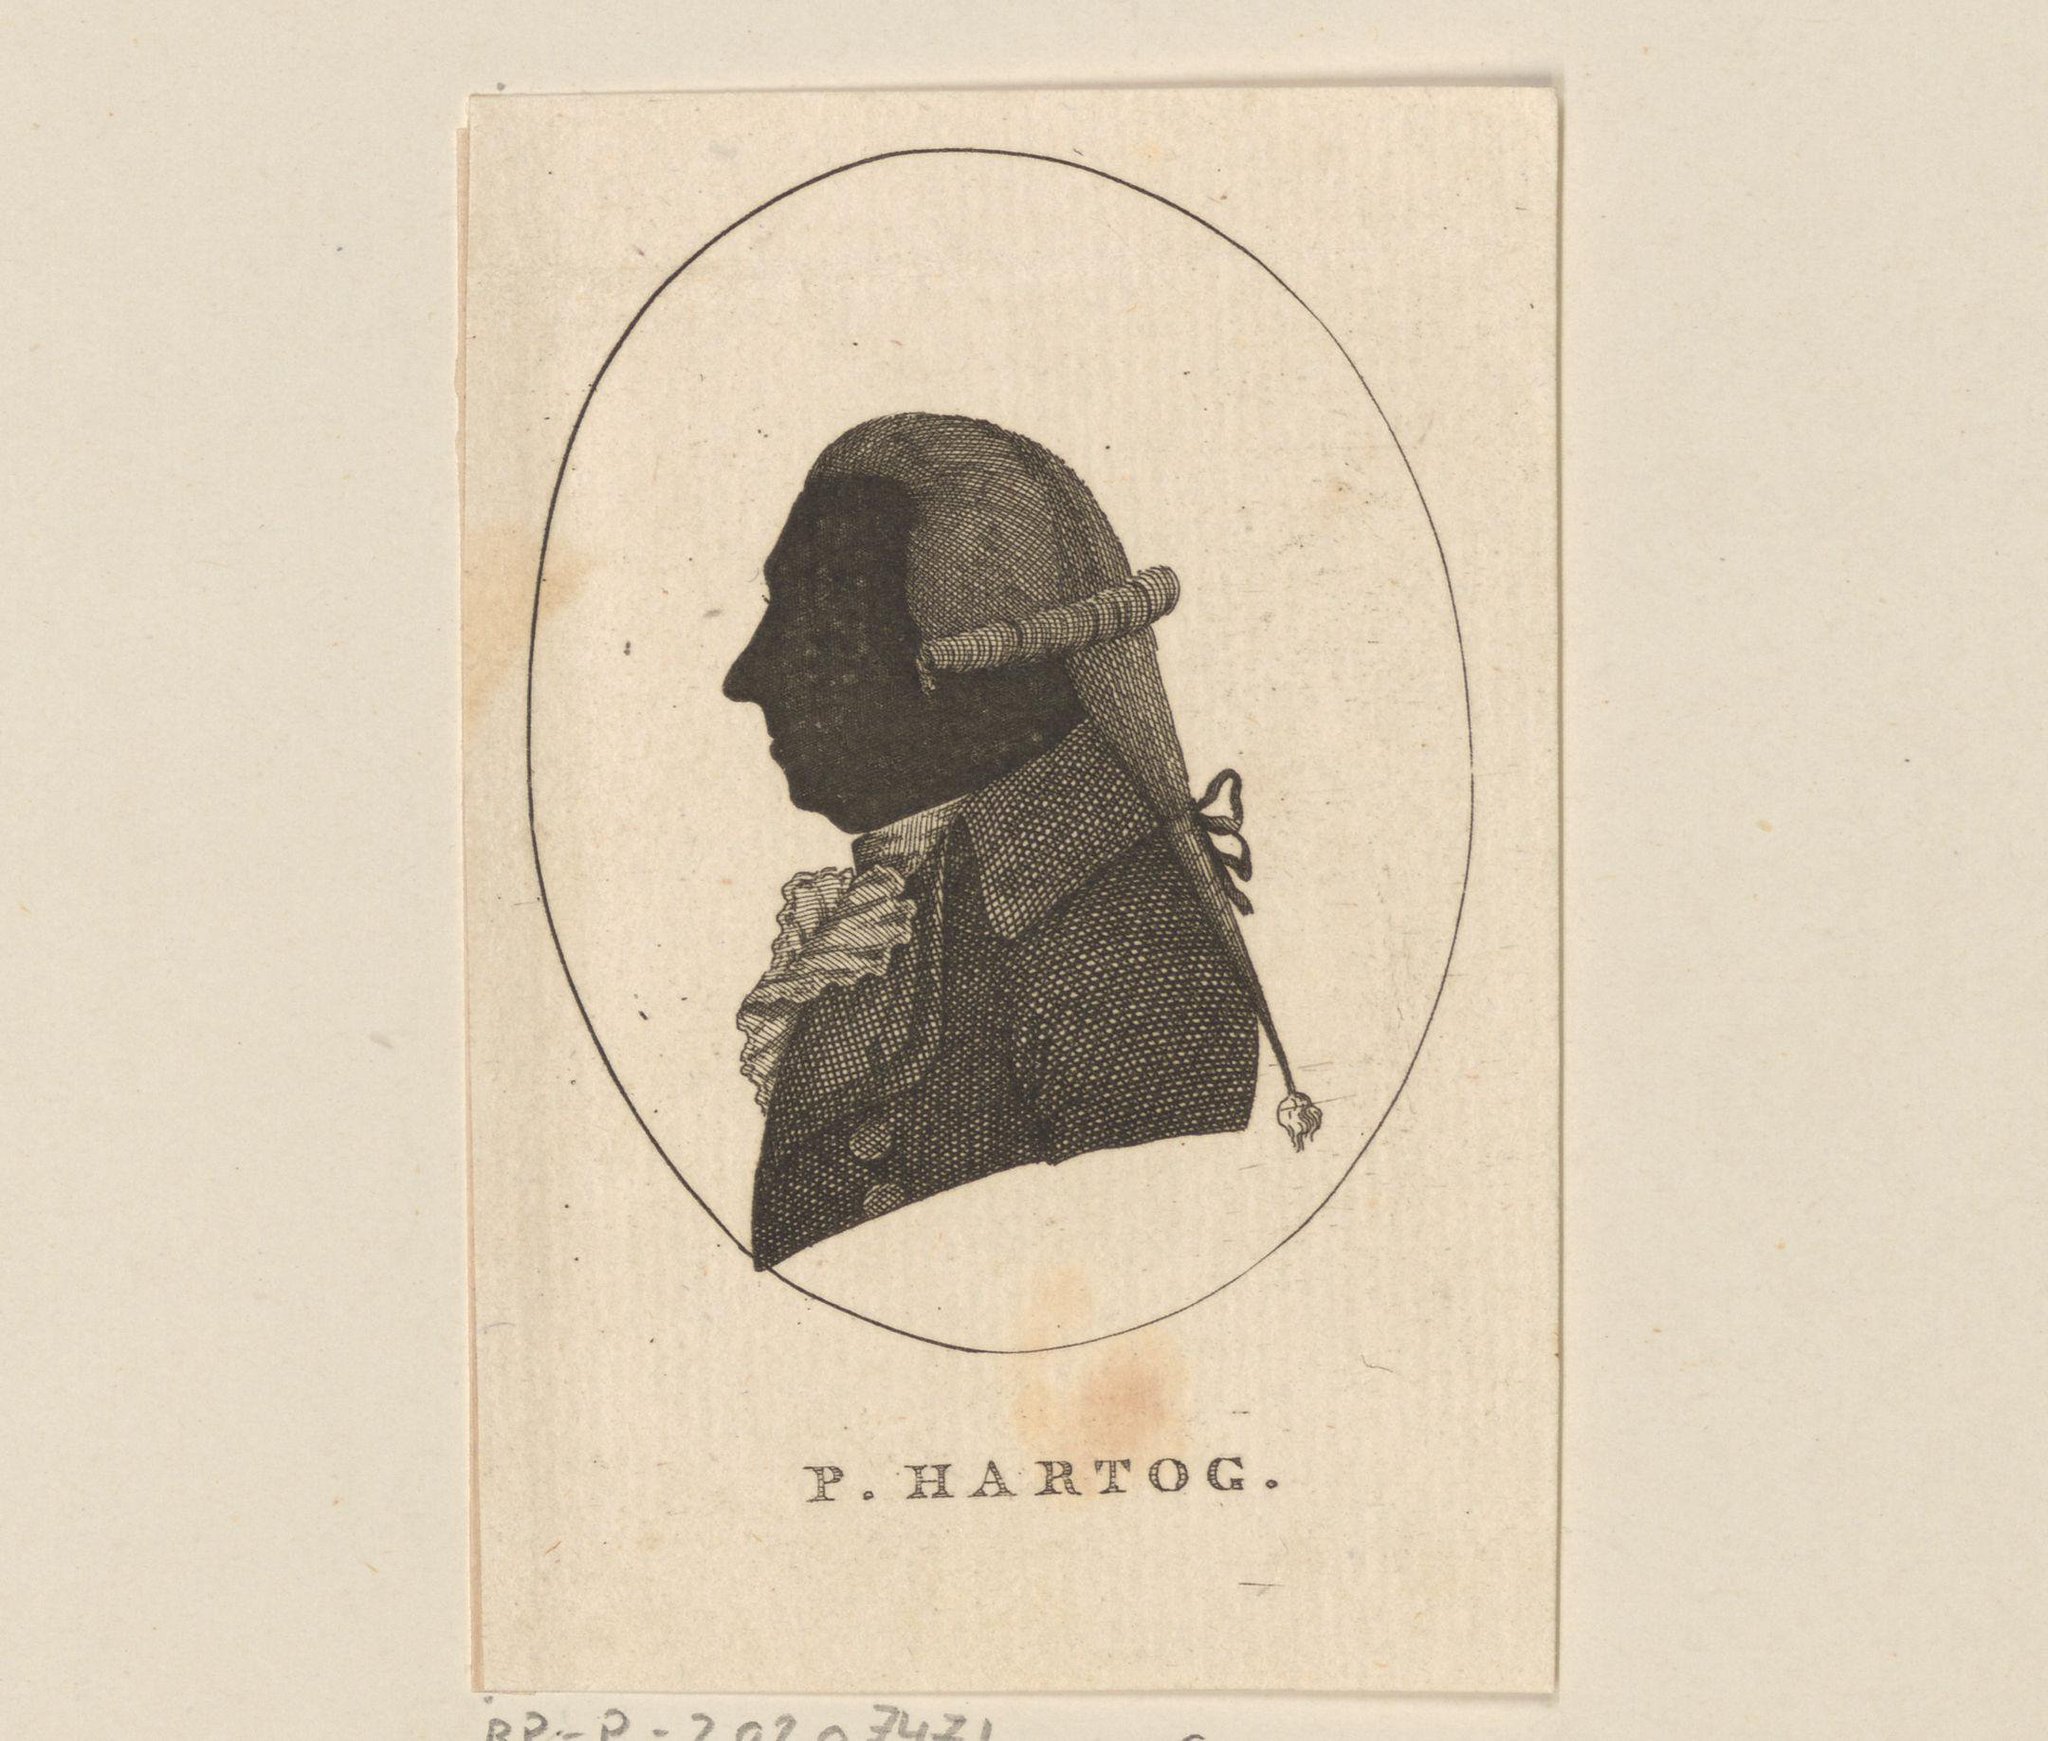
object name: book illustration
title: Silhouetportret van Paulus Hartog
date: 1799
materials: paper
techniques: etching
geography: amsterdam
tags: leiden, historical persons, politician, e.g. party leader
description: Prent uit: Rogge, Cornelis. Geschiedenis der staatsregeling, voor het Bataafsche volk. Amsterdam: Johannes Allart, 1799.